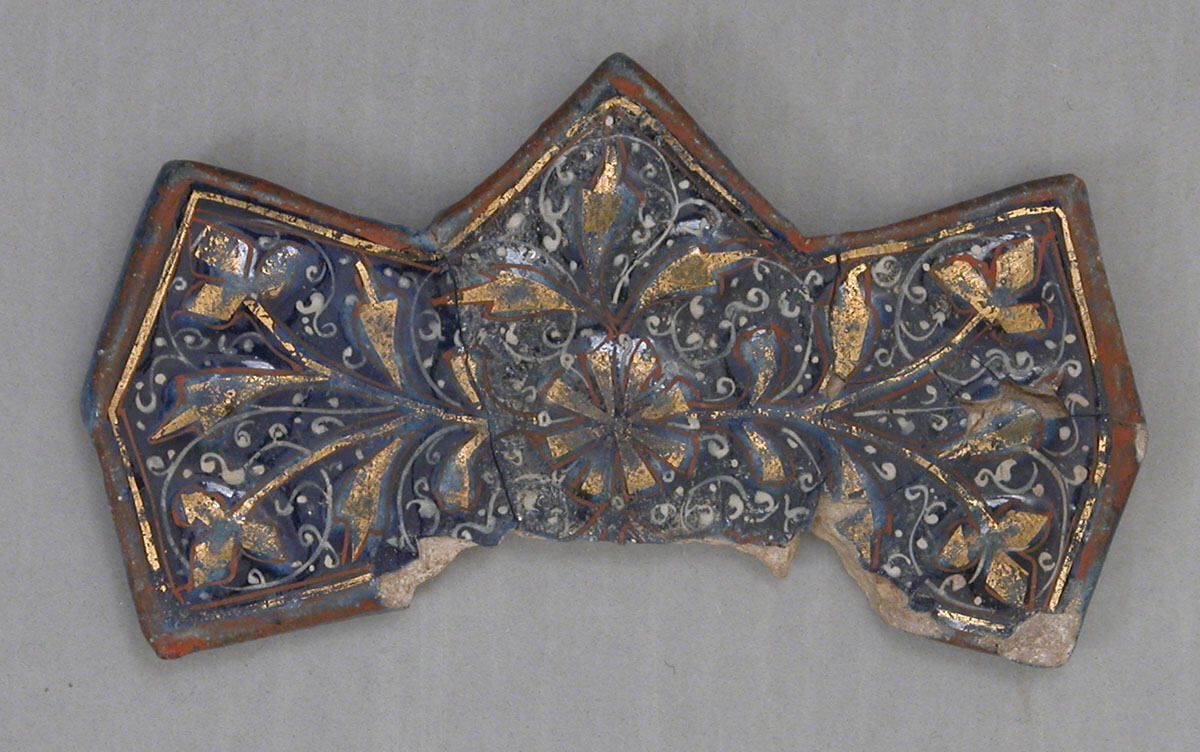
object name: tile fragment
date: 1251-1300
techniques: gilding, molding, overglaze, painting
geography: iran